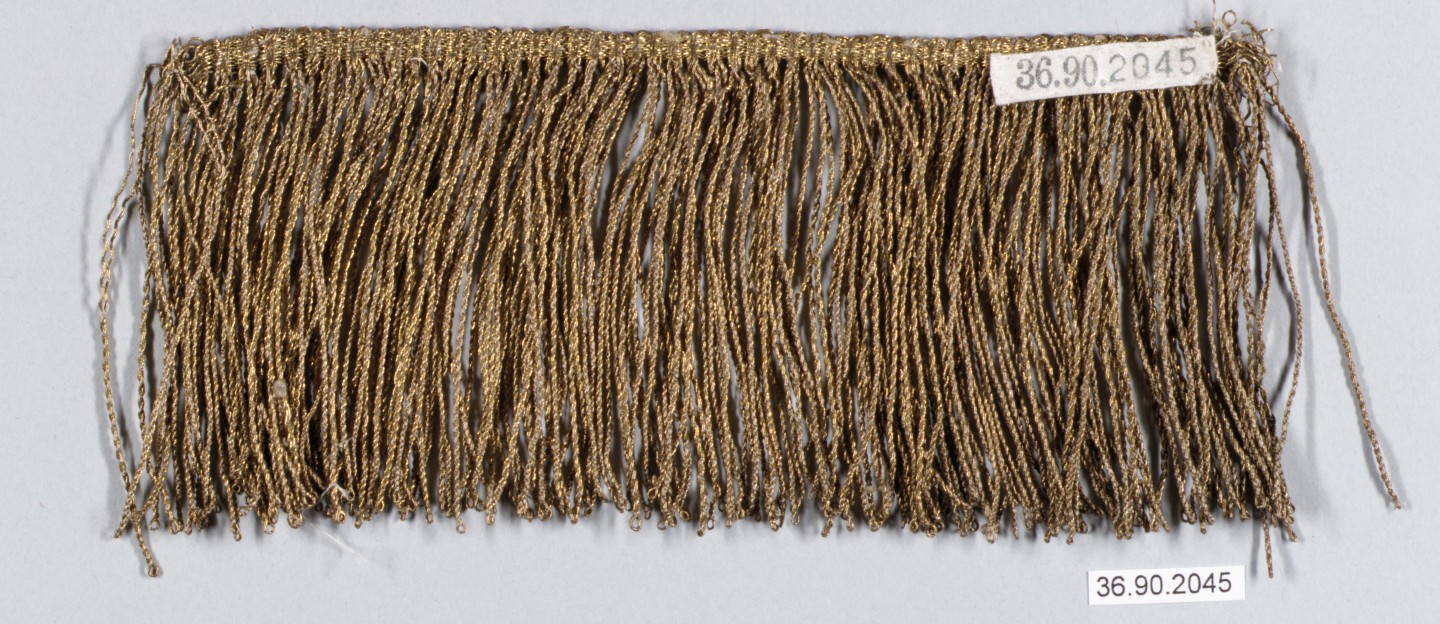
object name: fringe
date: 1701-1800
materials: metal thread, silk